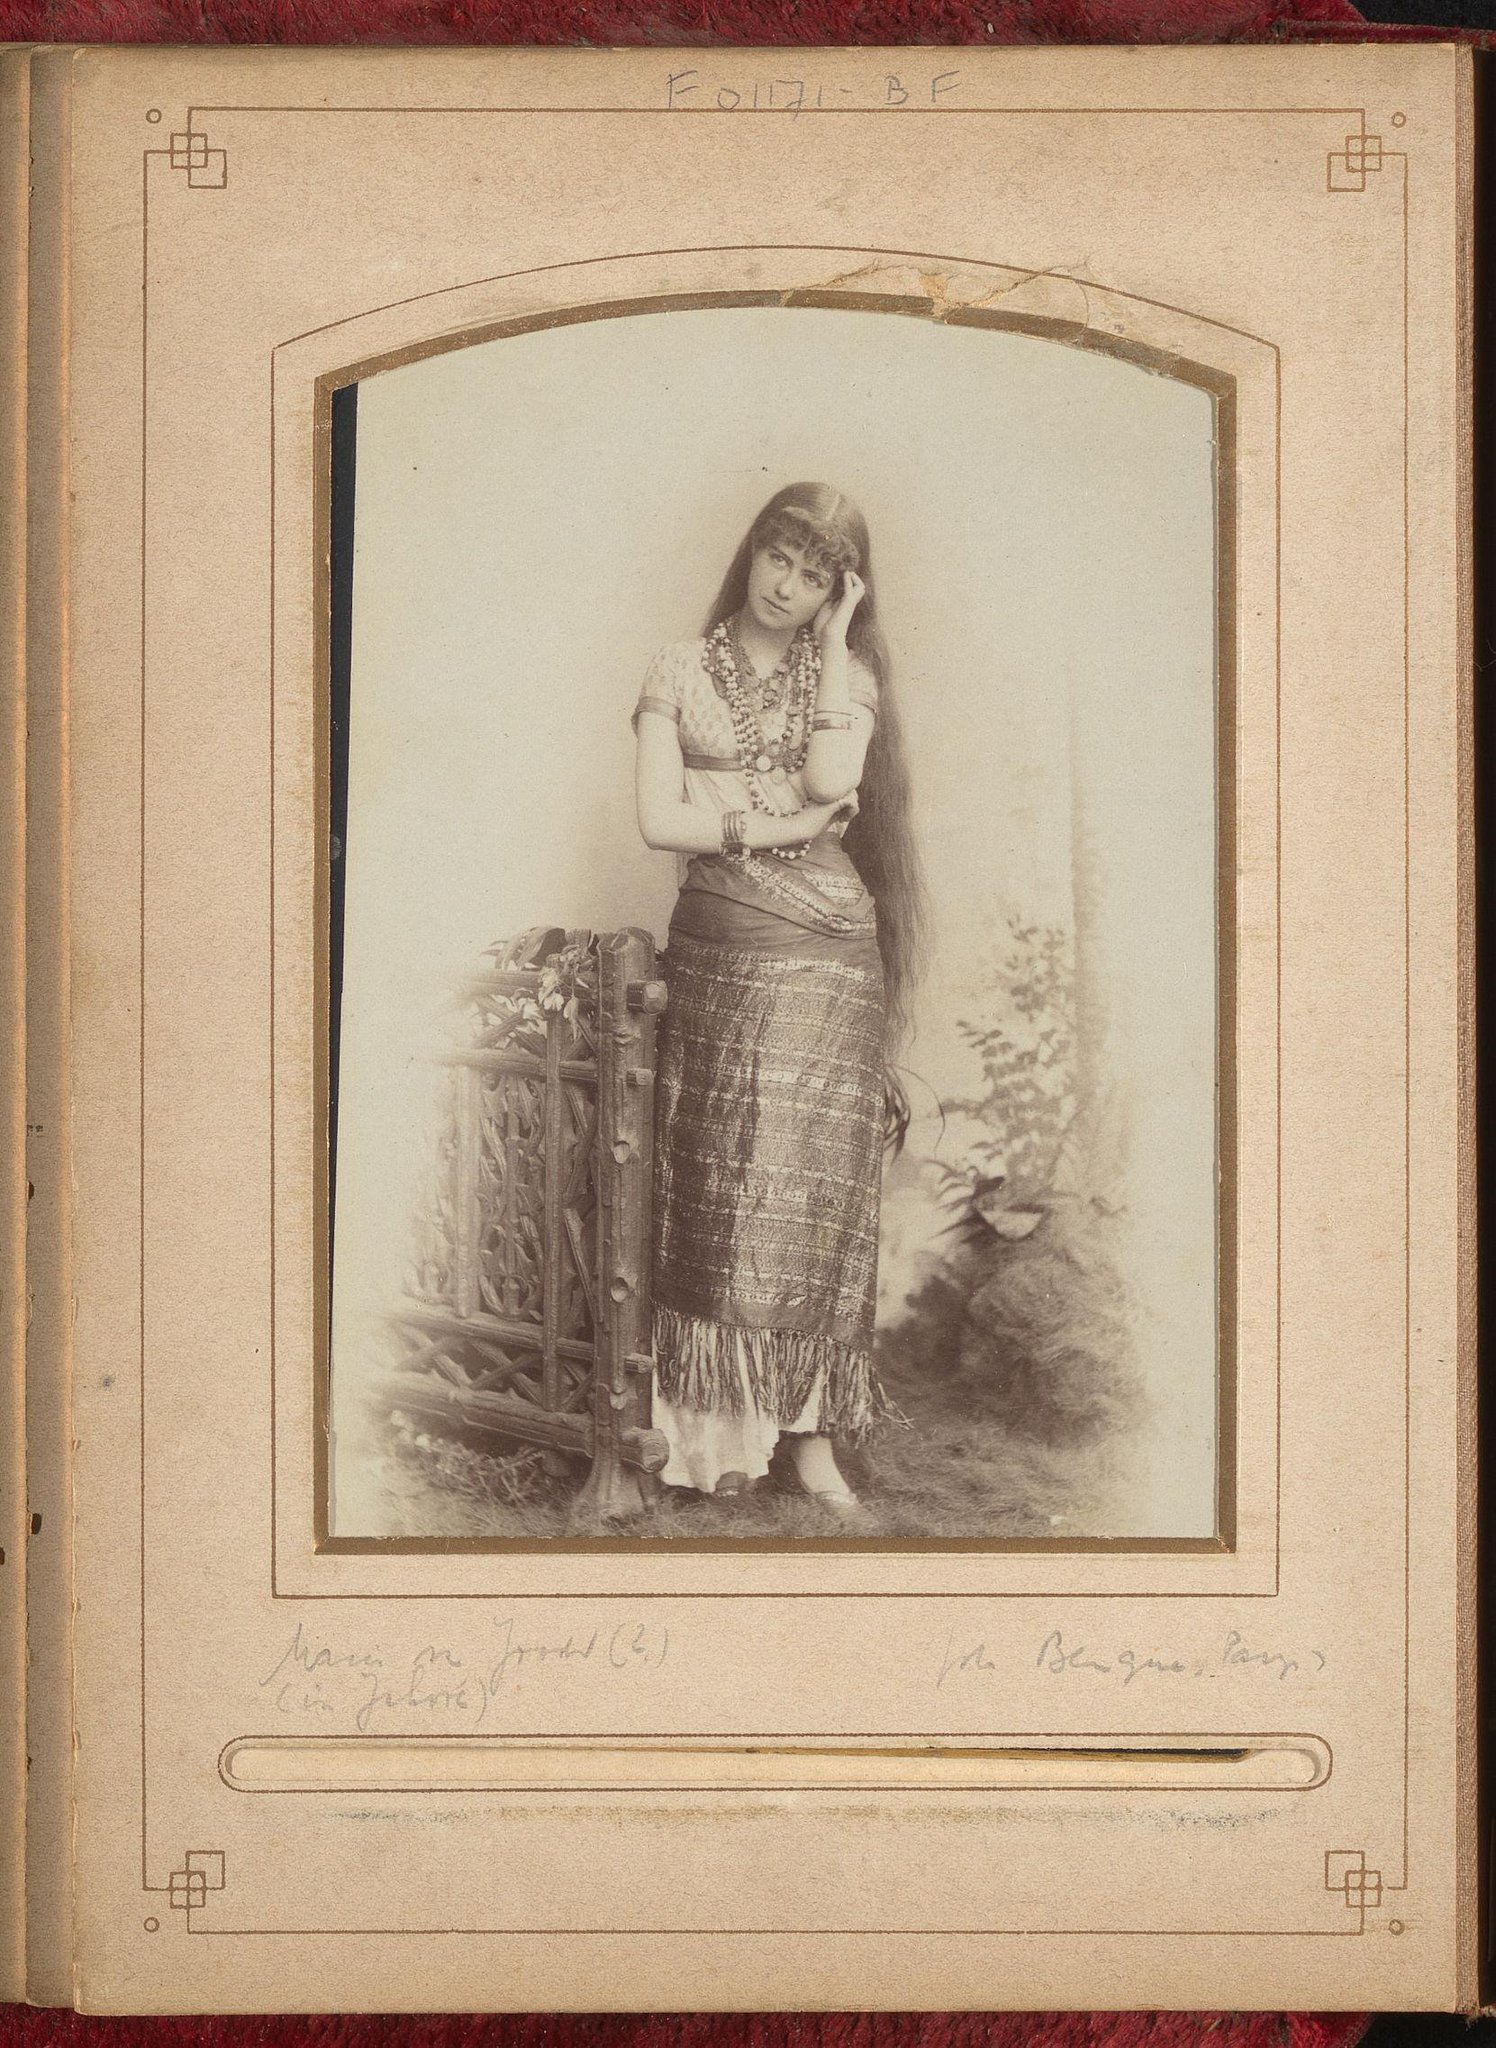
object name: cabinet photograph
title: Portret van een artieste, mogelijk Marie van Joodt ten Jahve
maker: wilhelm benque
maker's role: fotograaf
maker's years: 1843-1903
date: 1880-1910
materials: cardboard, photographic support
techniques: albumen print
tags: adult woman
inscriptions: inscription: ‘Benque & Co/ 33. Rue Boissy D'Anglas/ Exposition 5, Rue Royale/ Paris/ Lith. K. Krziwanek Vienne’, name: ‘Marie van Joodt ten Jahve’, name: ‘Benque & Co 33. Rue Boissy D'Anglas Paris’